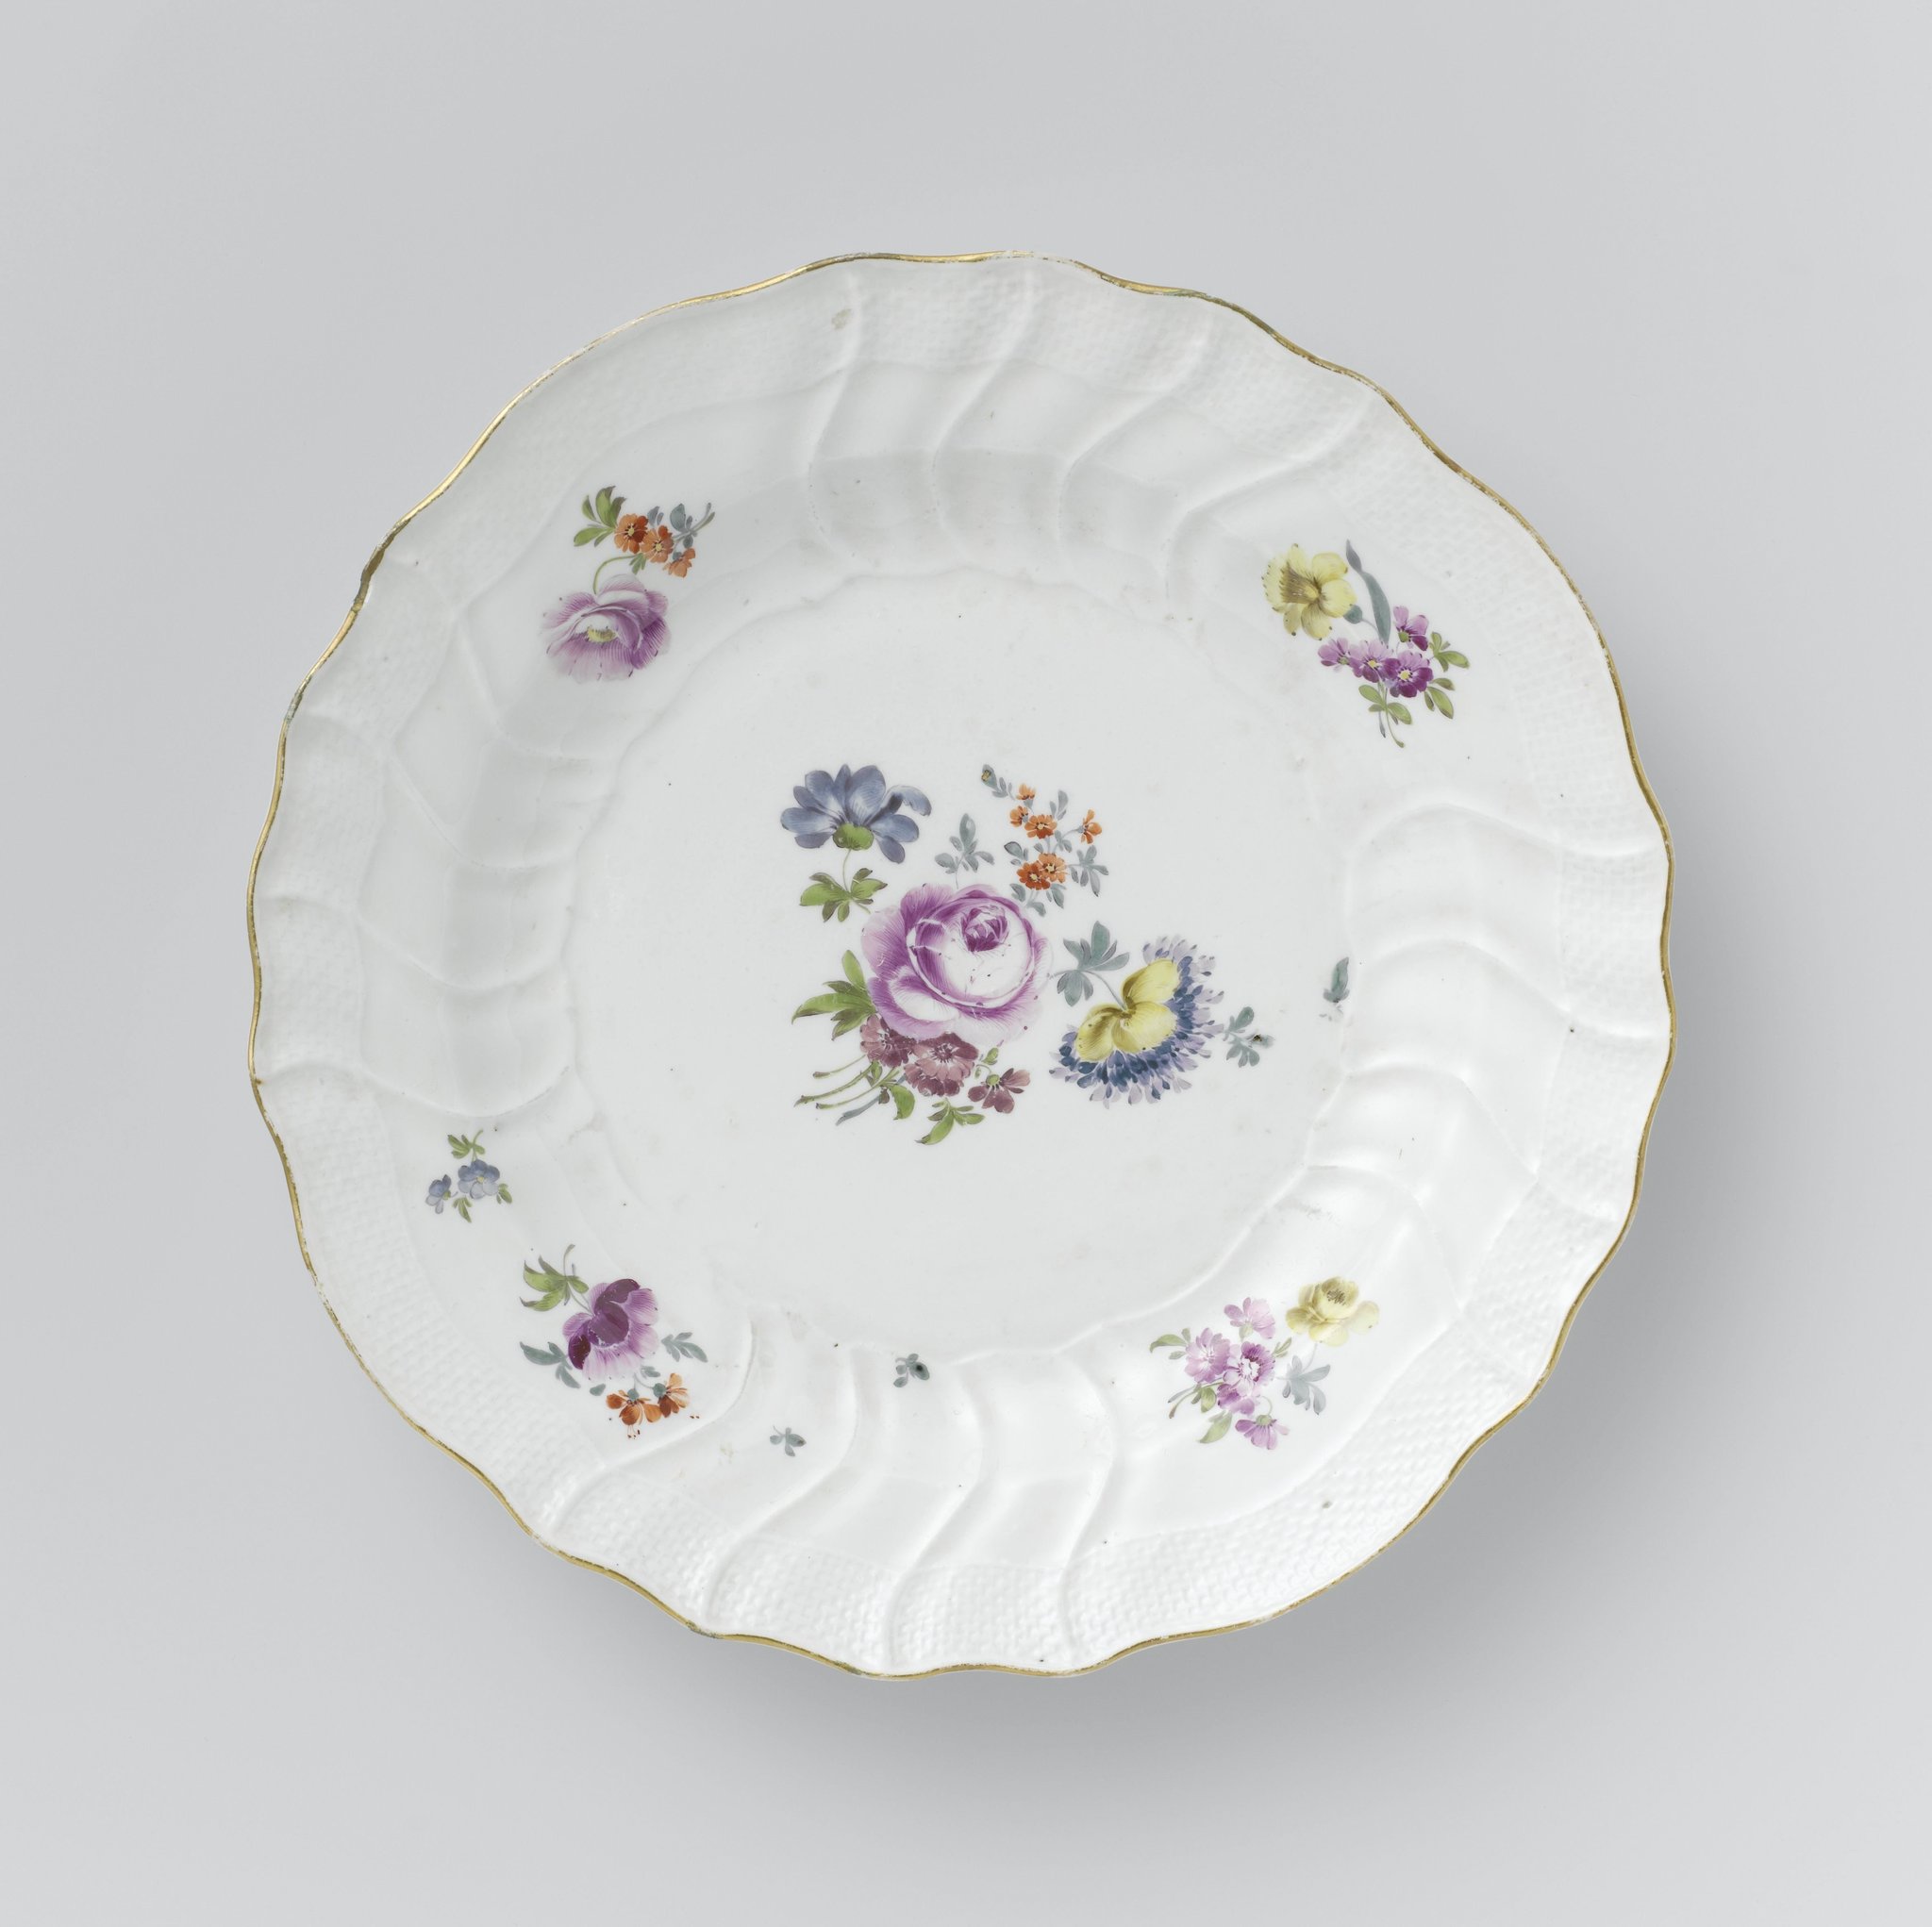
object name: eating drinking utensil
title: Bord, veelkleurig beschilderd met Deutsche Blumen, insekten en vruchten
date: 1750-1760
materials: porcelain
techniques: painted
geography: meissen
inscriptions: factory mark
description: Rond bord van beschilderd porselein. De rand is versierd met het Neuozier-patroon. De beschildering bestaat uit Deutsche Blumen, insekten en vruchten. Het bord is gemerkt en hoort bij een servies (BK-17474-1 t/m BK-17474-253).